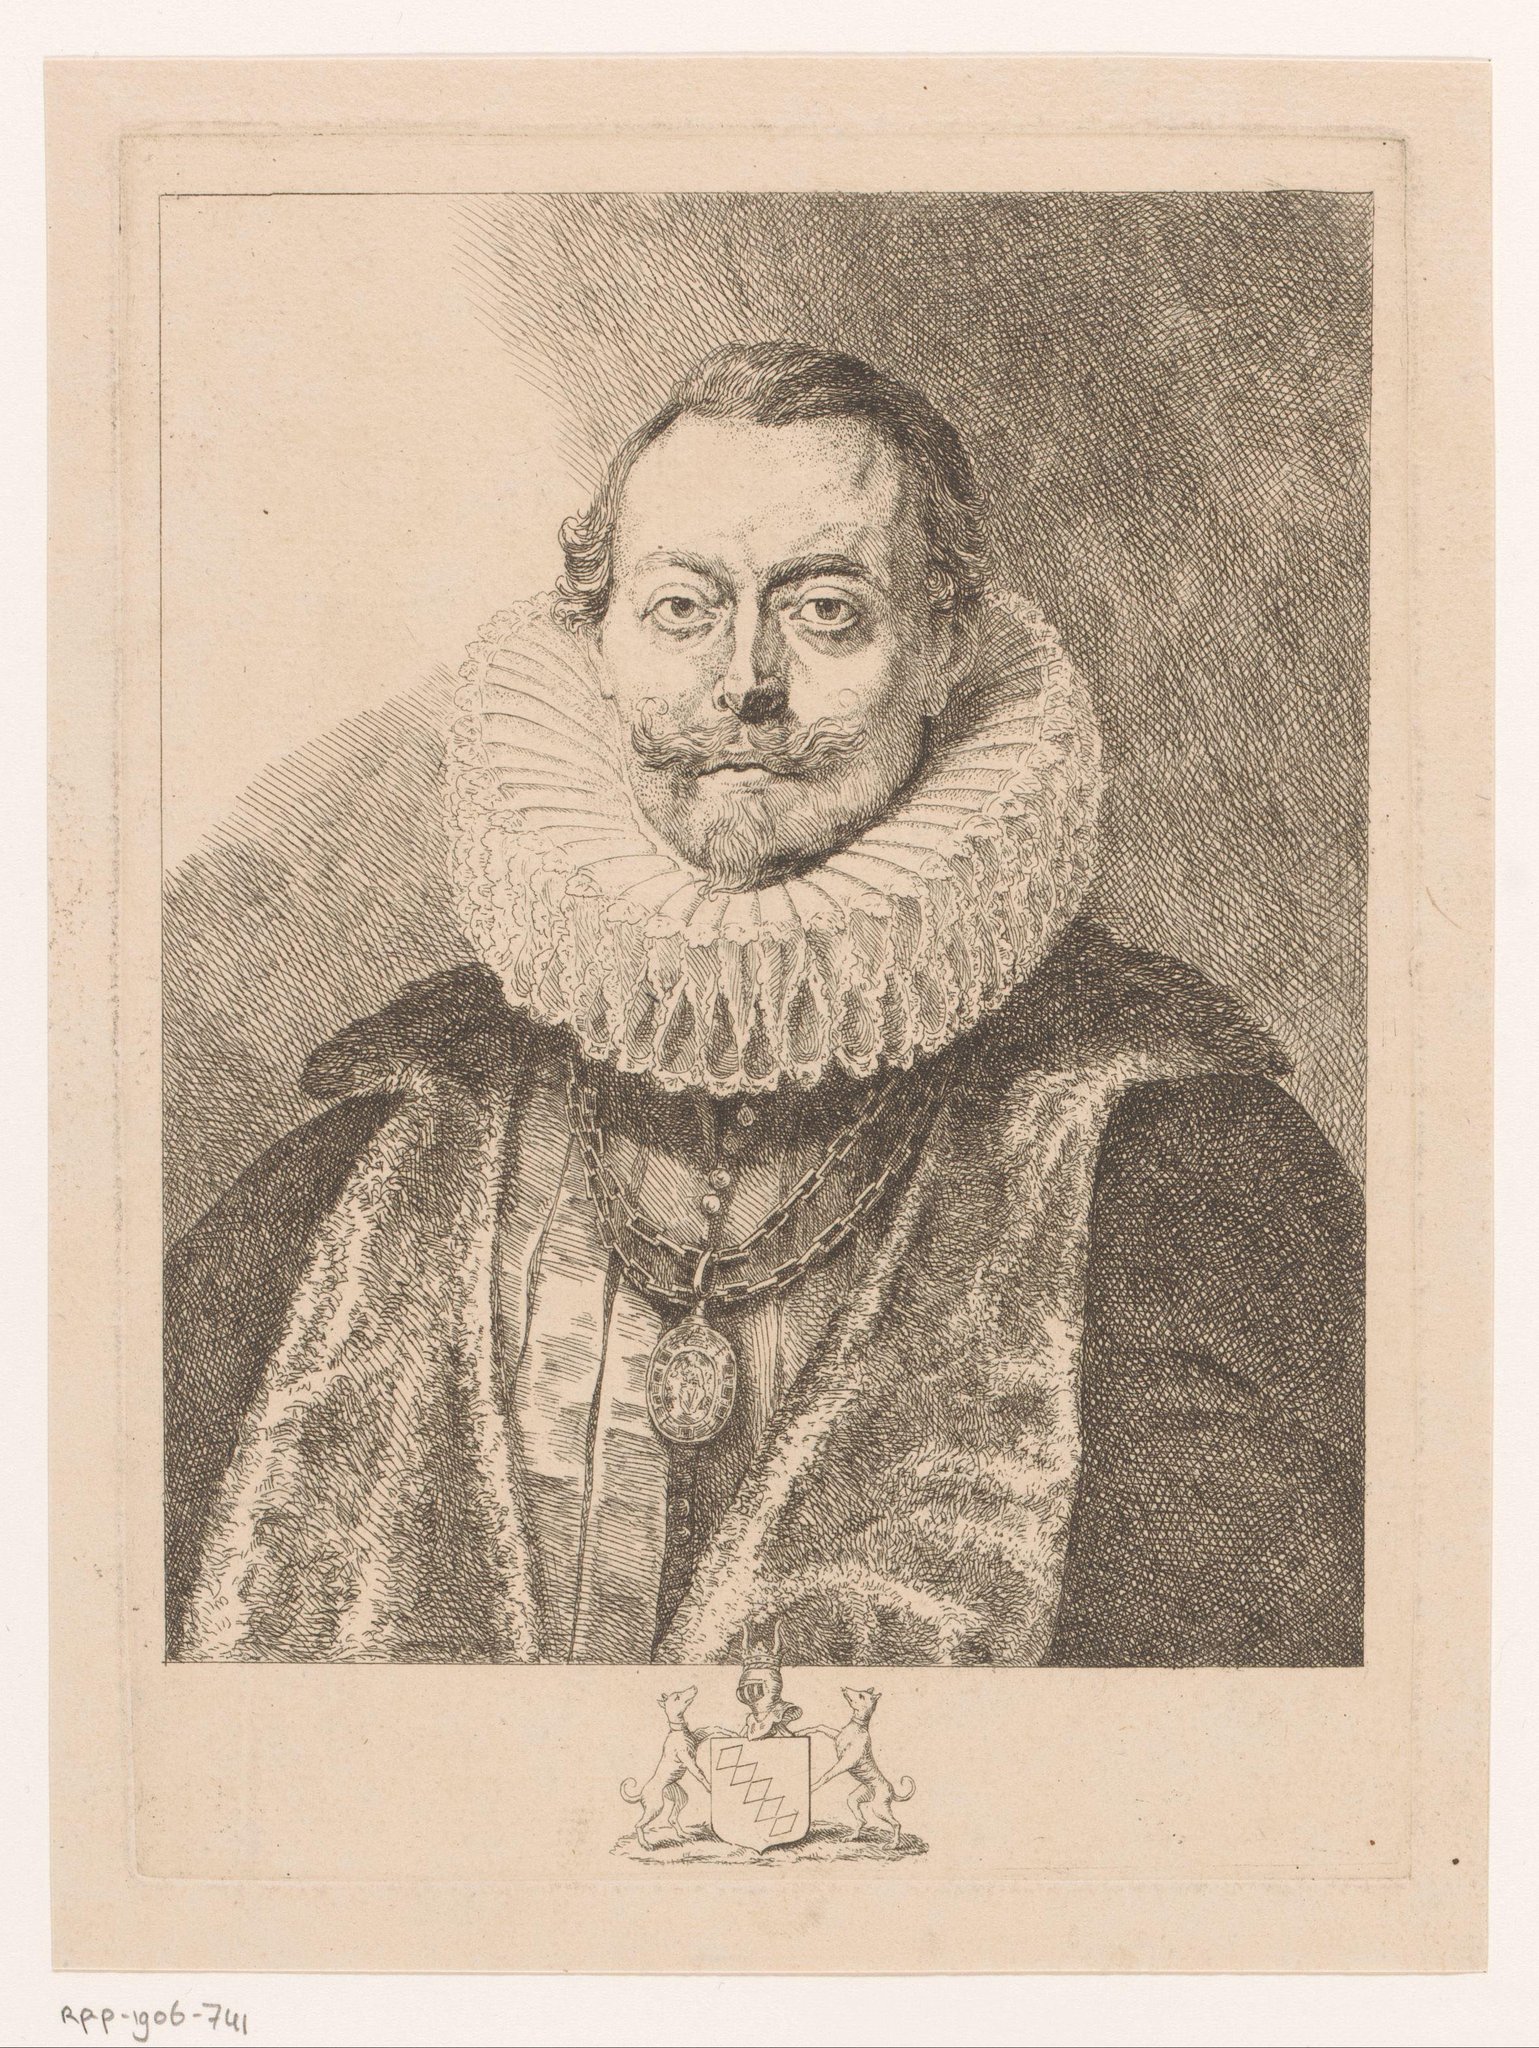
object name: print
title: Portret van Frederik de Marselaer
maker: andreas bernardus de quertenmont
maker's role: draughtsman, print maker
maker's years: 1750-1835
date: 1777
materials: paper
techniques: etching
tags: moustache, adult man, historical persons, armorial bearing, heraldry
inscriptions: collector's mark: Lugt 2228